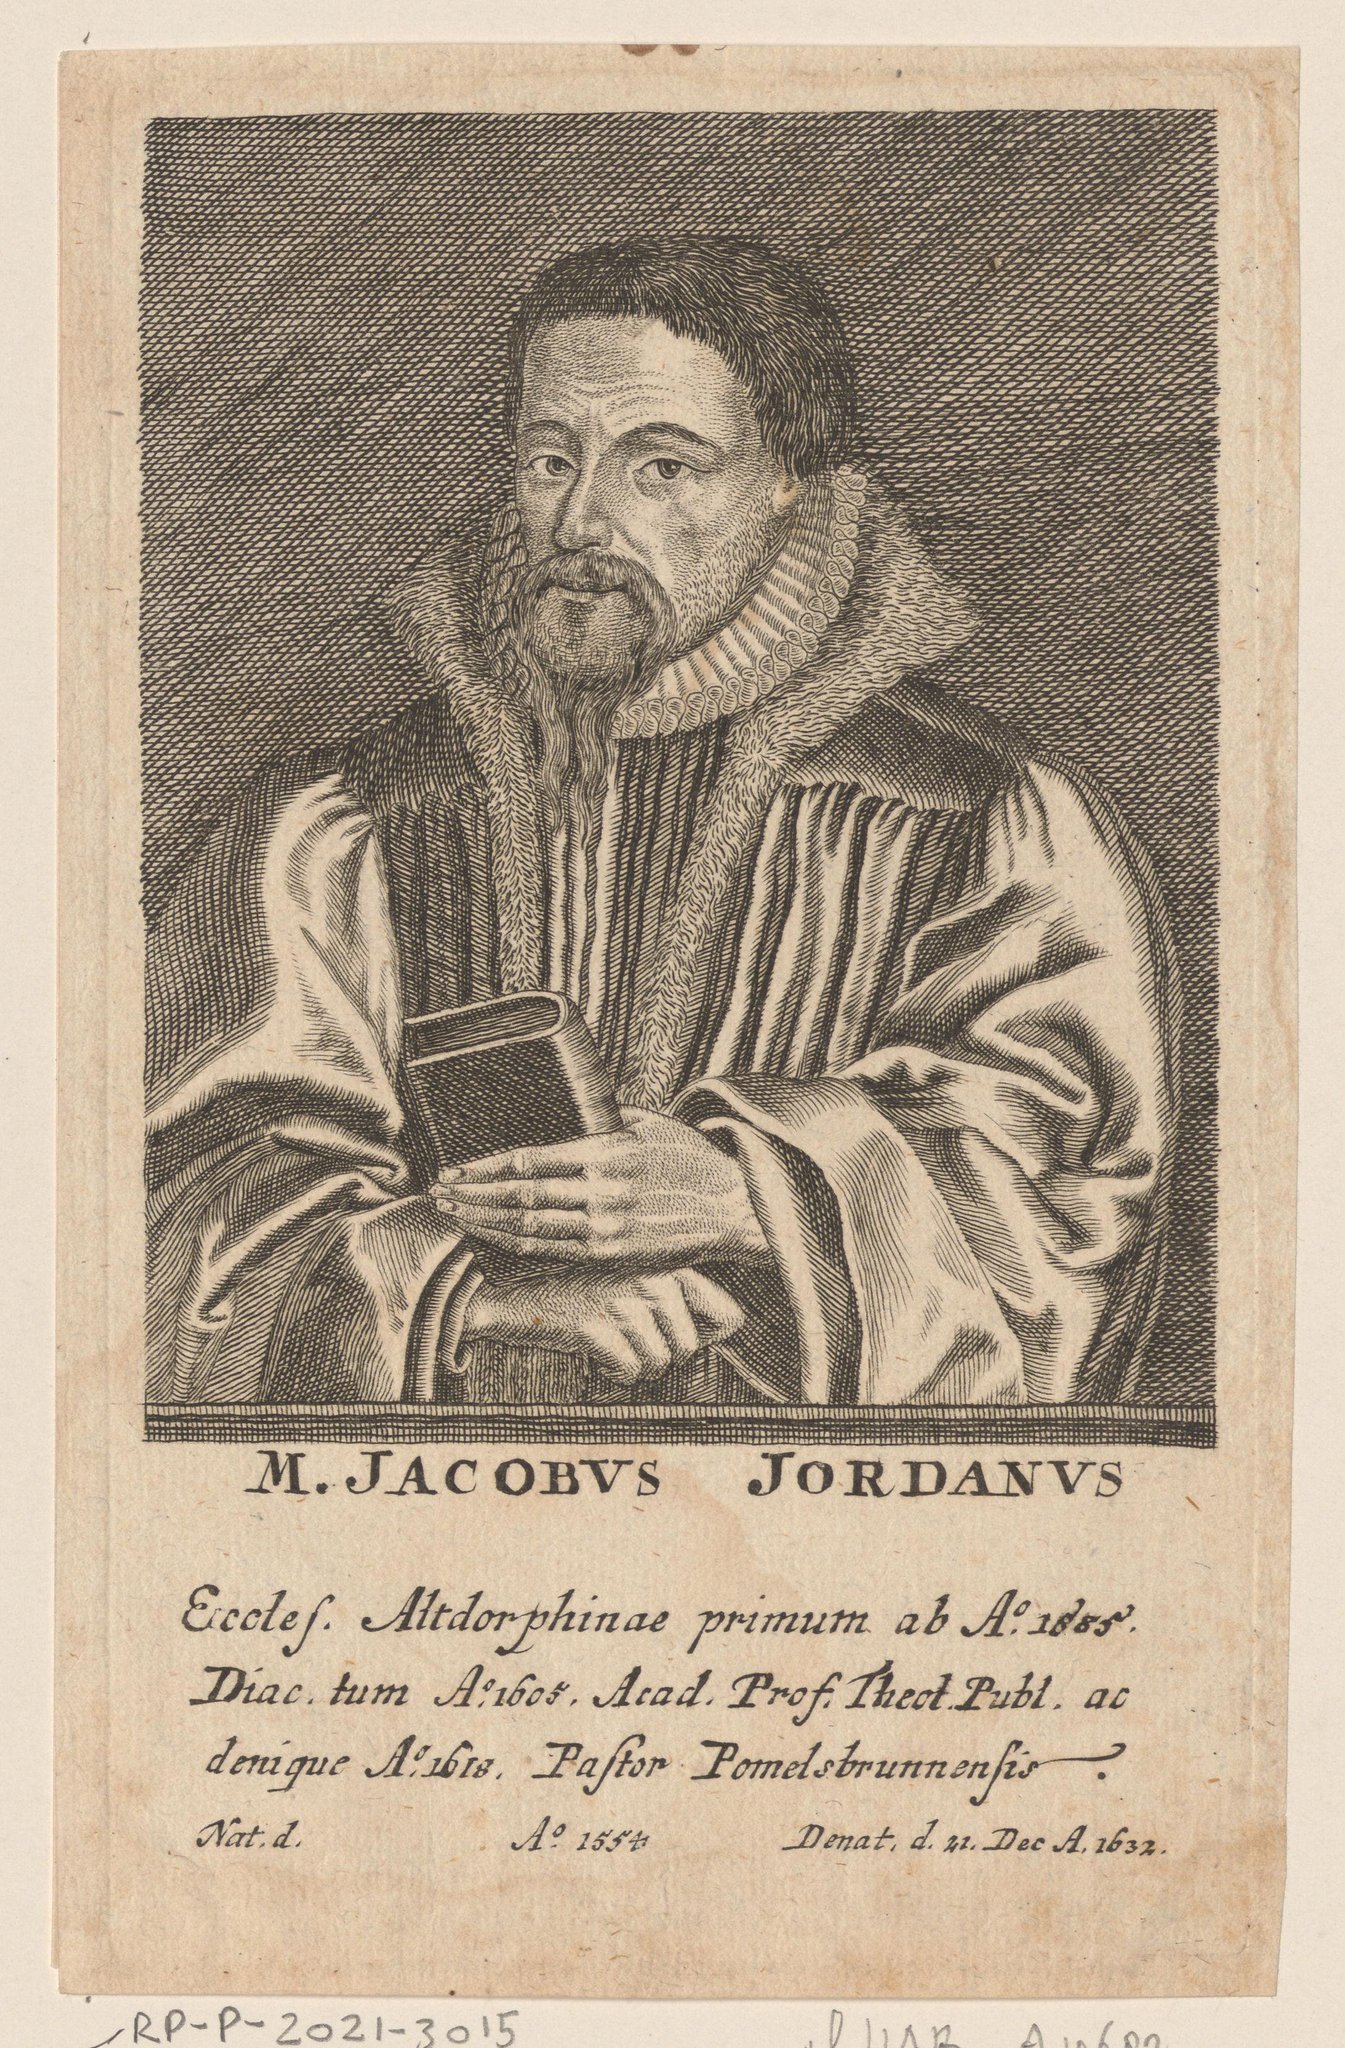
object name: print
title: Portret van Jakob Jordan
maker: Anonymous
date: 1722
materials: paper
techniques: engraving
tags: theologian, historical persons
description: Prent waarschijnlijk uit: Zeltner, Gustav Georg. Vitae Theologorum Altorphinorum (...). Neurenberg & Altdorf: erven Johann Daniel Tauber, 1722.